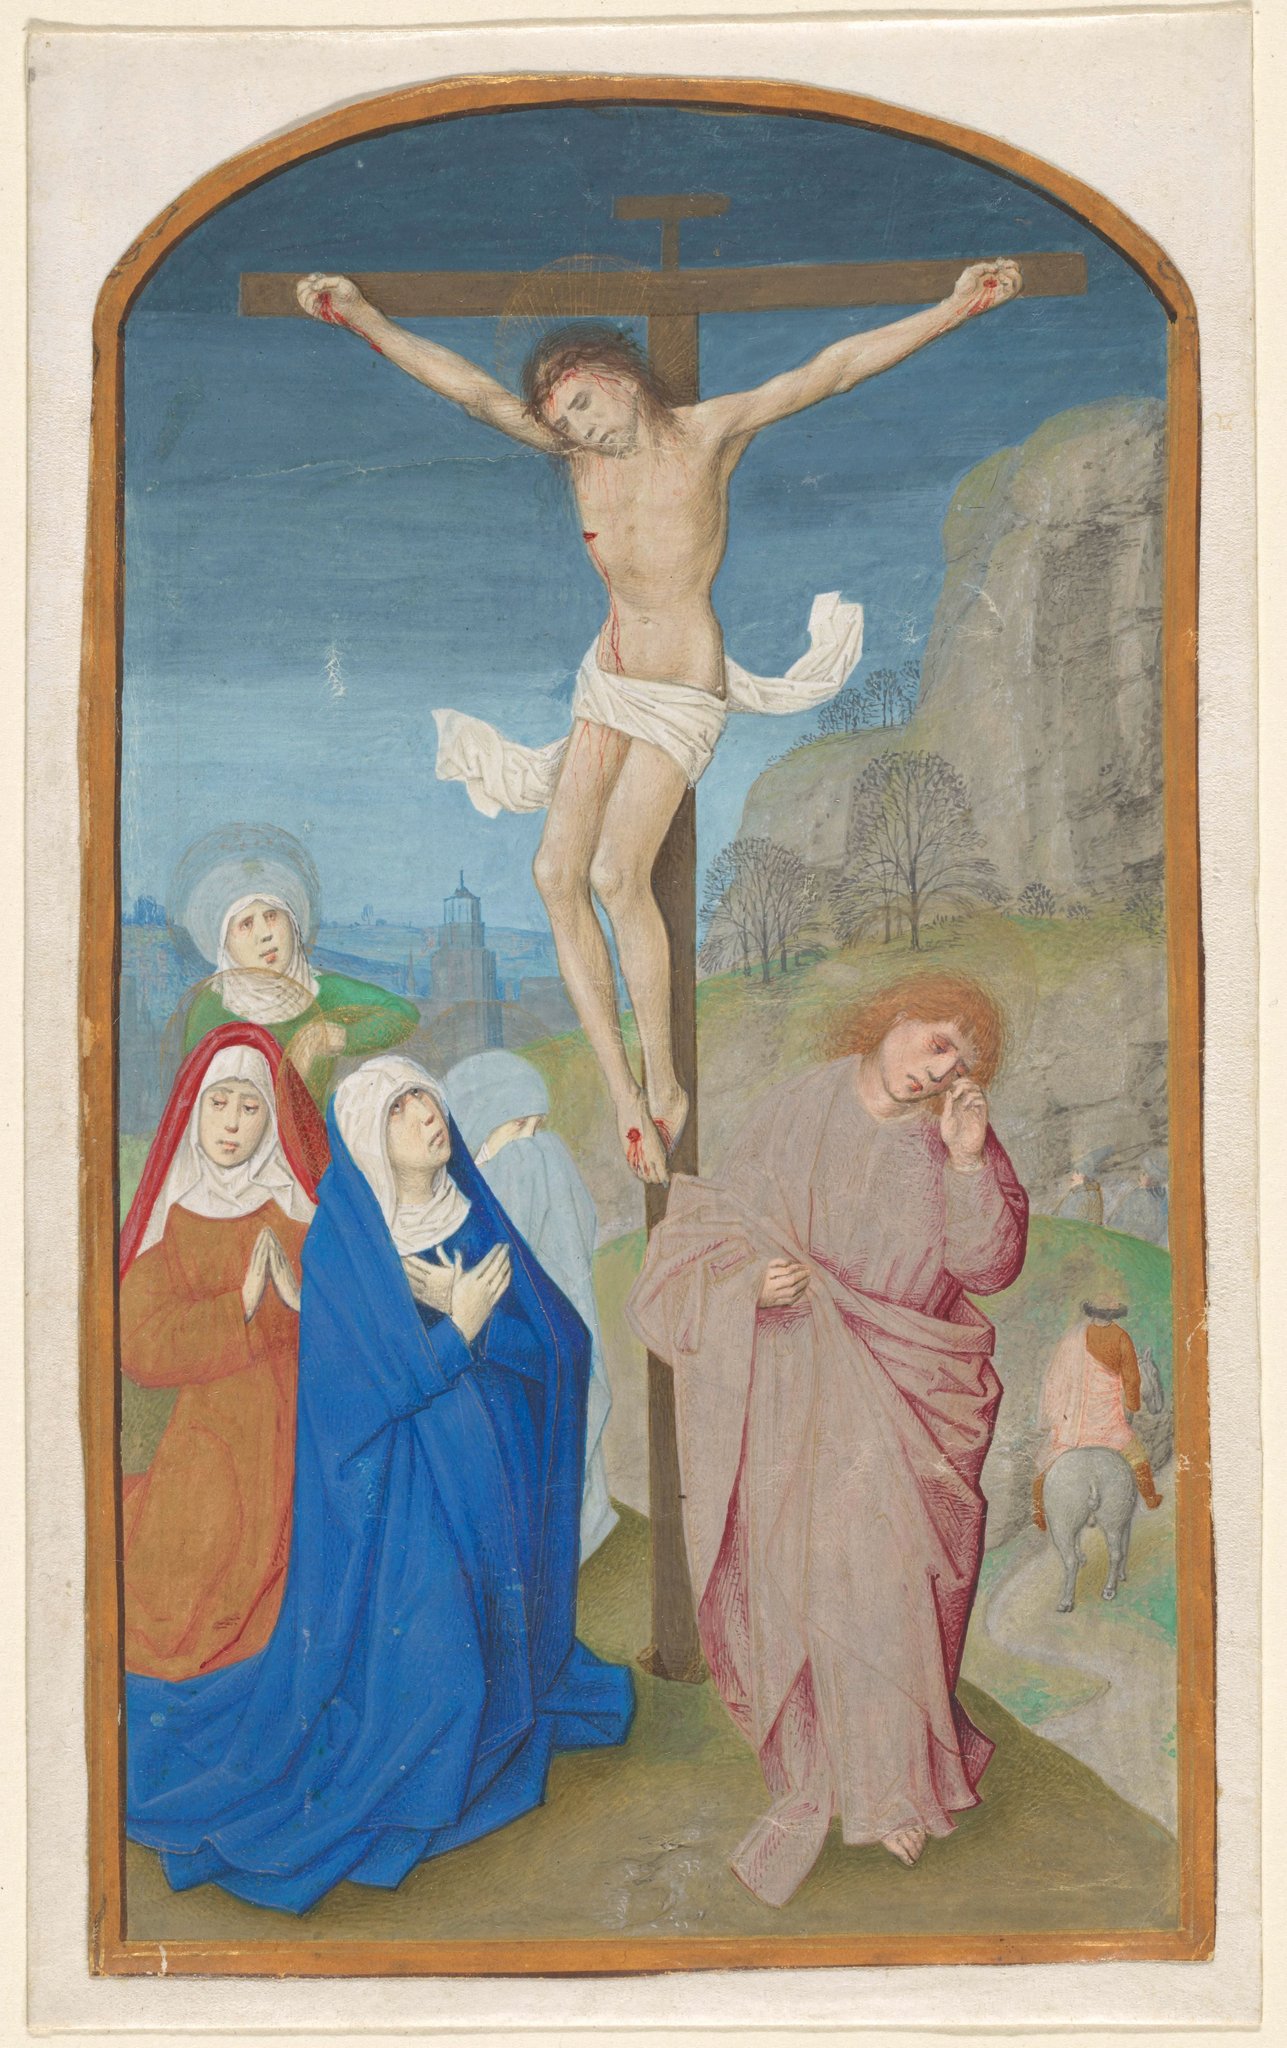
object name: miniature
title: Christus aan het kruis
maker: meester van het getijdenboek van maximiliaan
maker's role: draughtsman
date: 1480-1520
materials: gouache, parchment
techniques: brush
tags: crucified christ with mary, john, and mary magdalene